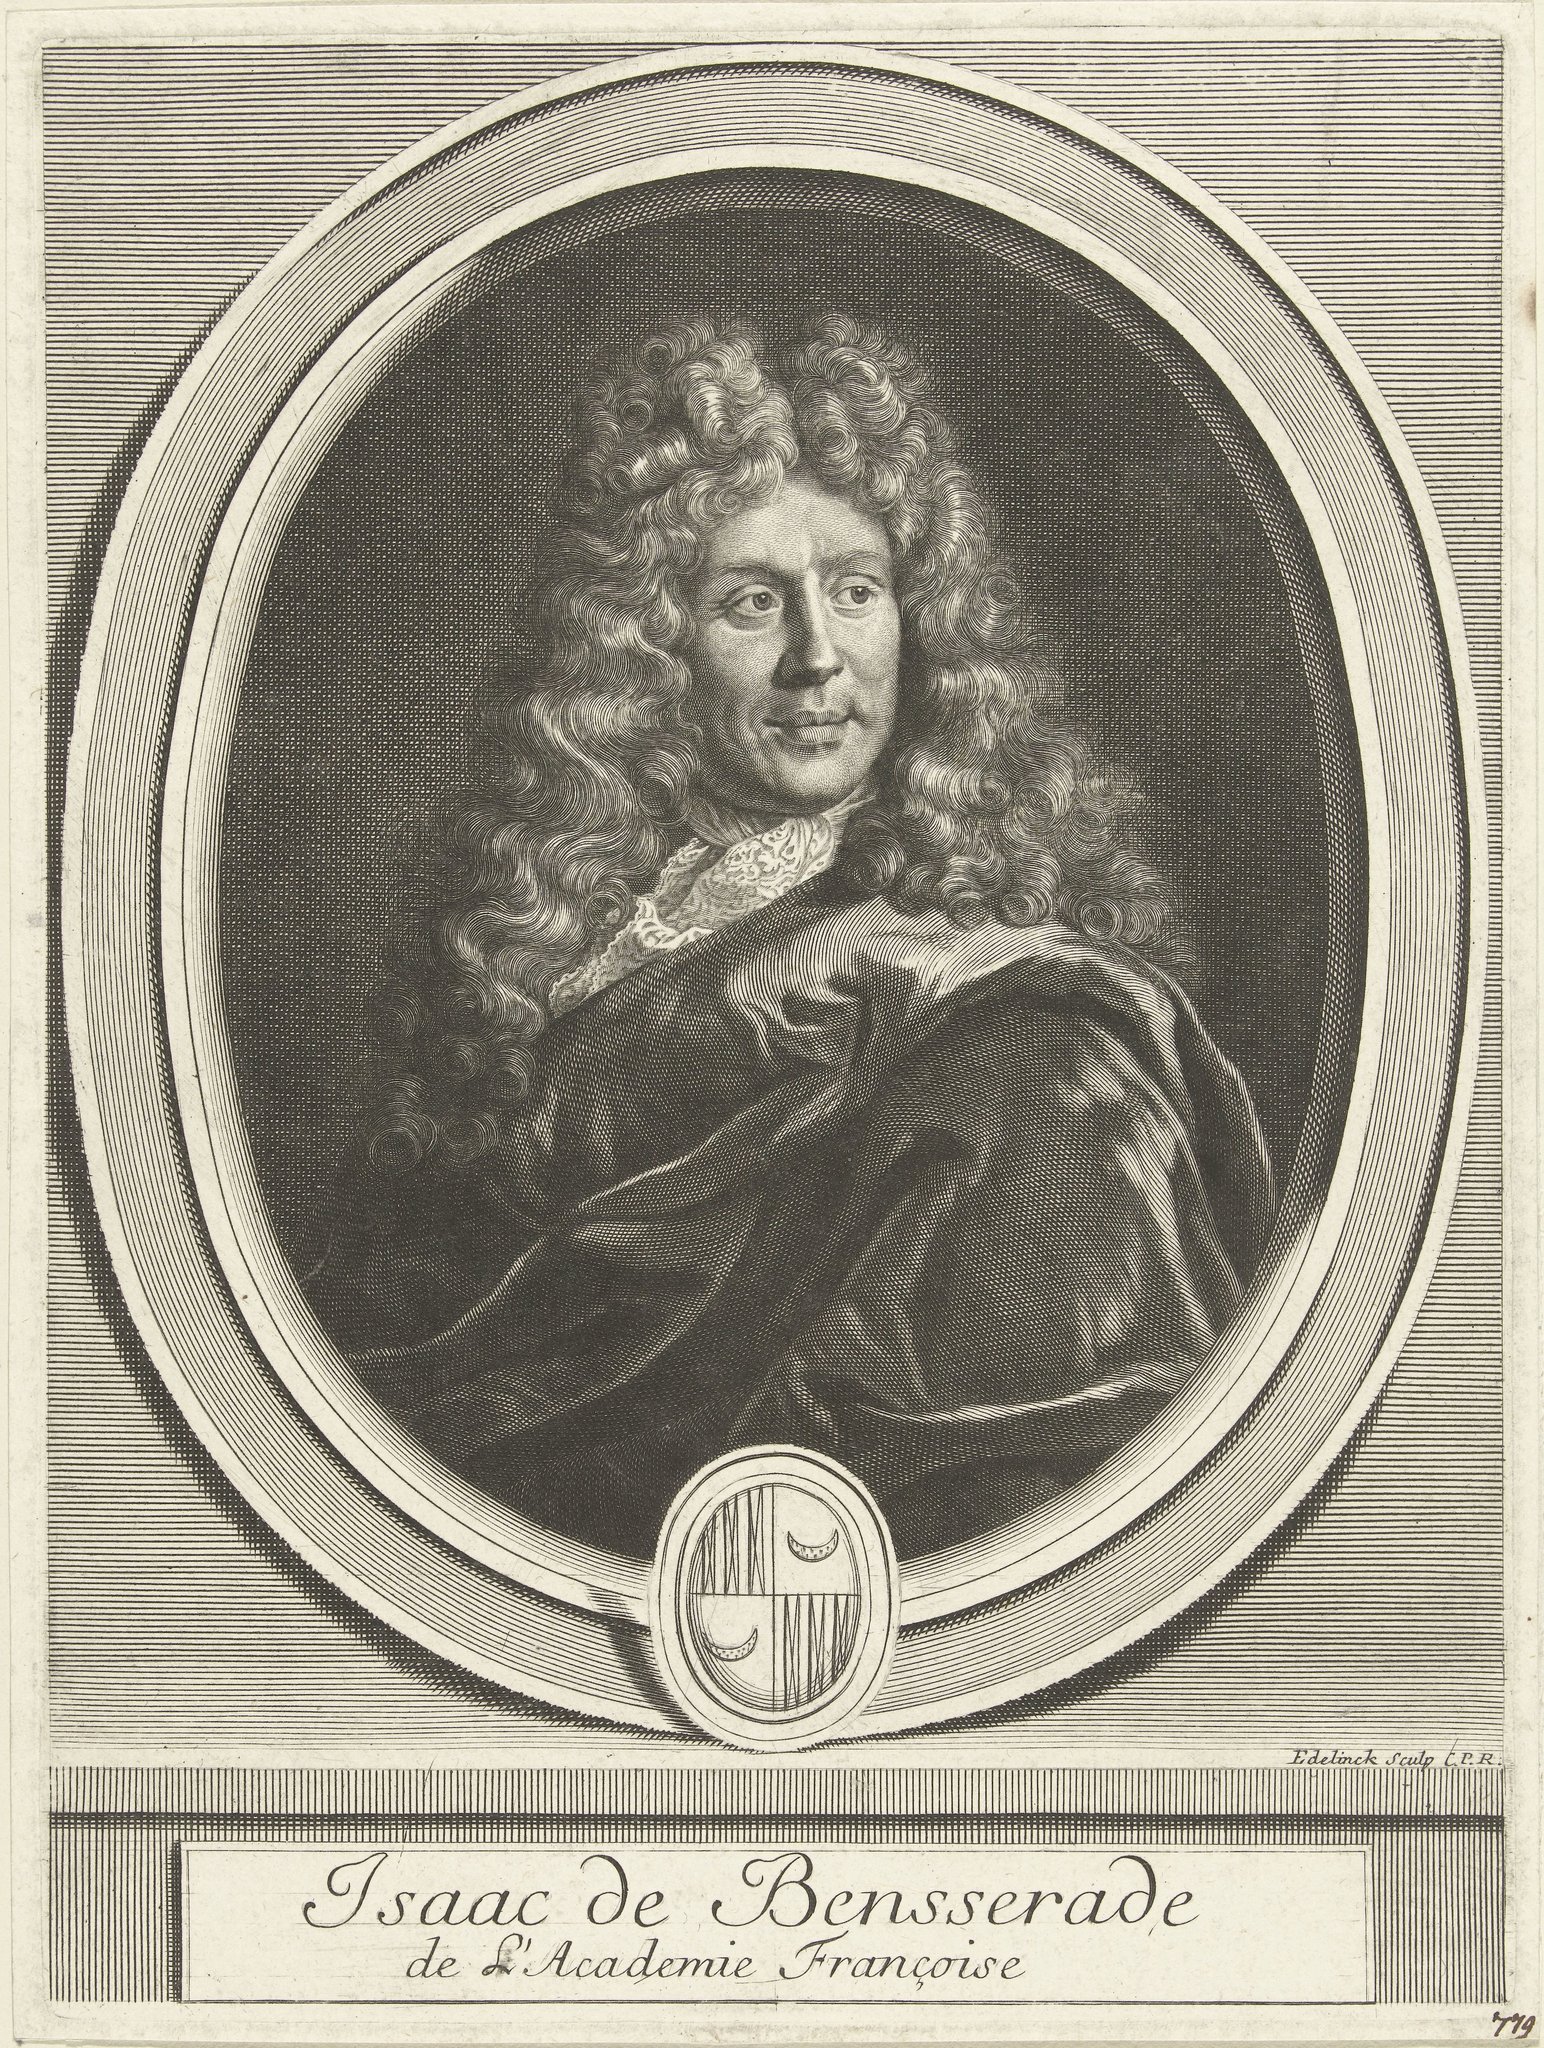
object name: print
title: Portret van Isaac de Benserade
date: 1666-1707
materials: paper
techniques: engraving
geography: paris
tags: france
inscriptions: collector's mark: Lugt 240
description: Portret van de dichter Isaac de Benserade (1612-1691), afgebeeld in ovale omlijsting met wapen.